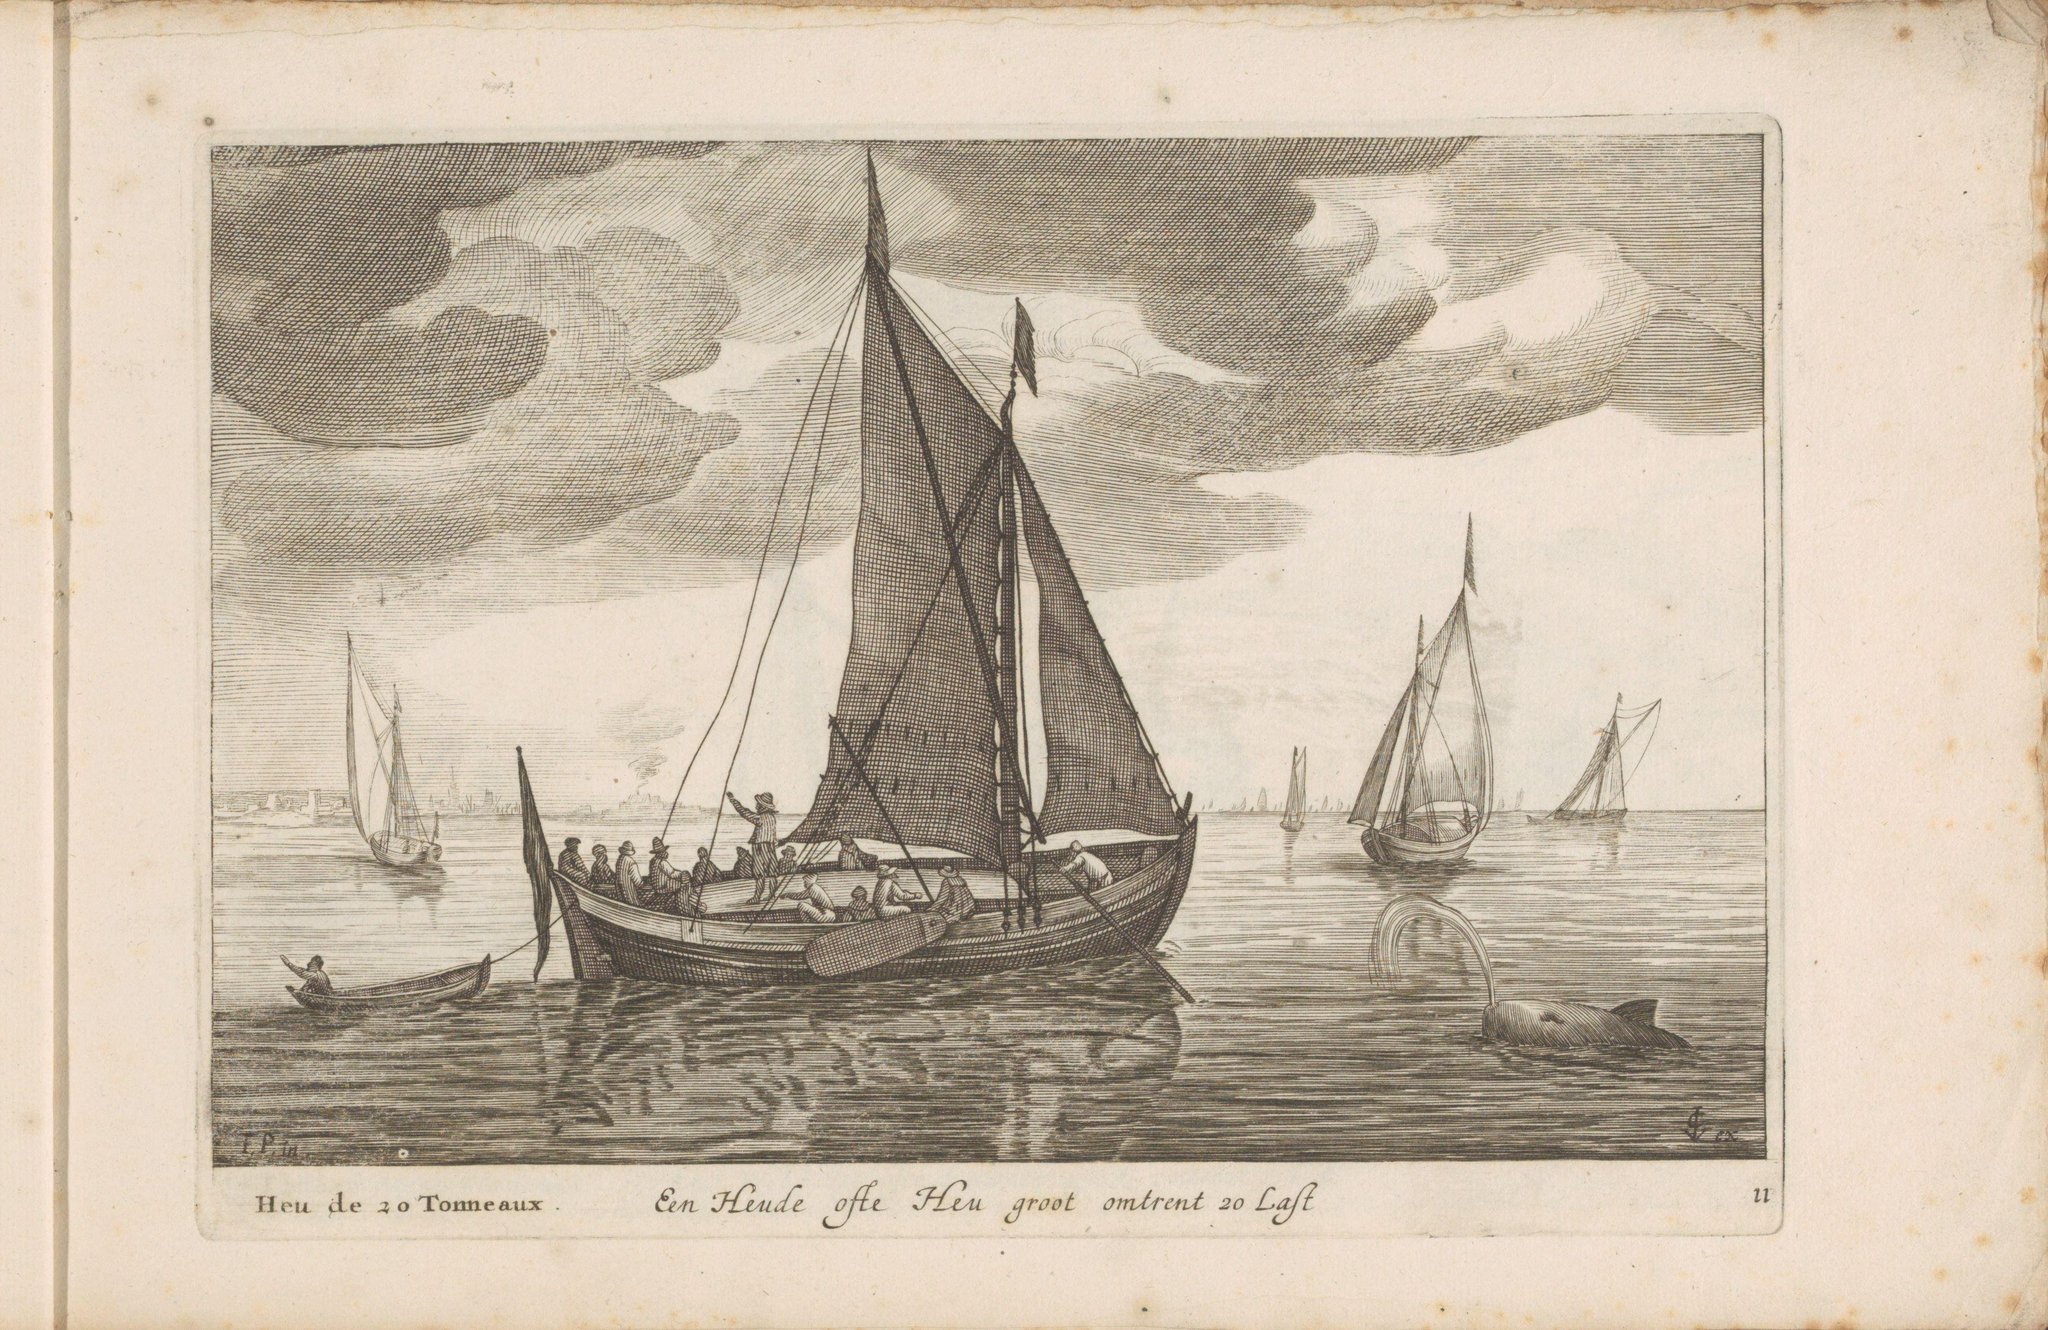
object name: print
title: Heude of heu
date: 1627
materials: paper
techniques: engraving, etching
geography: amsterdam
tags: sailing-ship, sailing-boat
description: Een heude of heu op het water. Rechts een bruinvis. De prent maakt deel uit van een album.